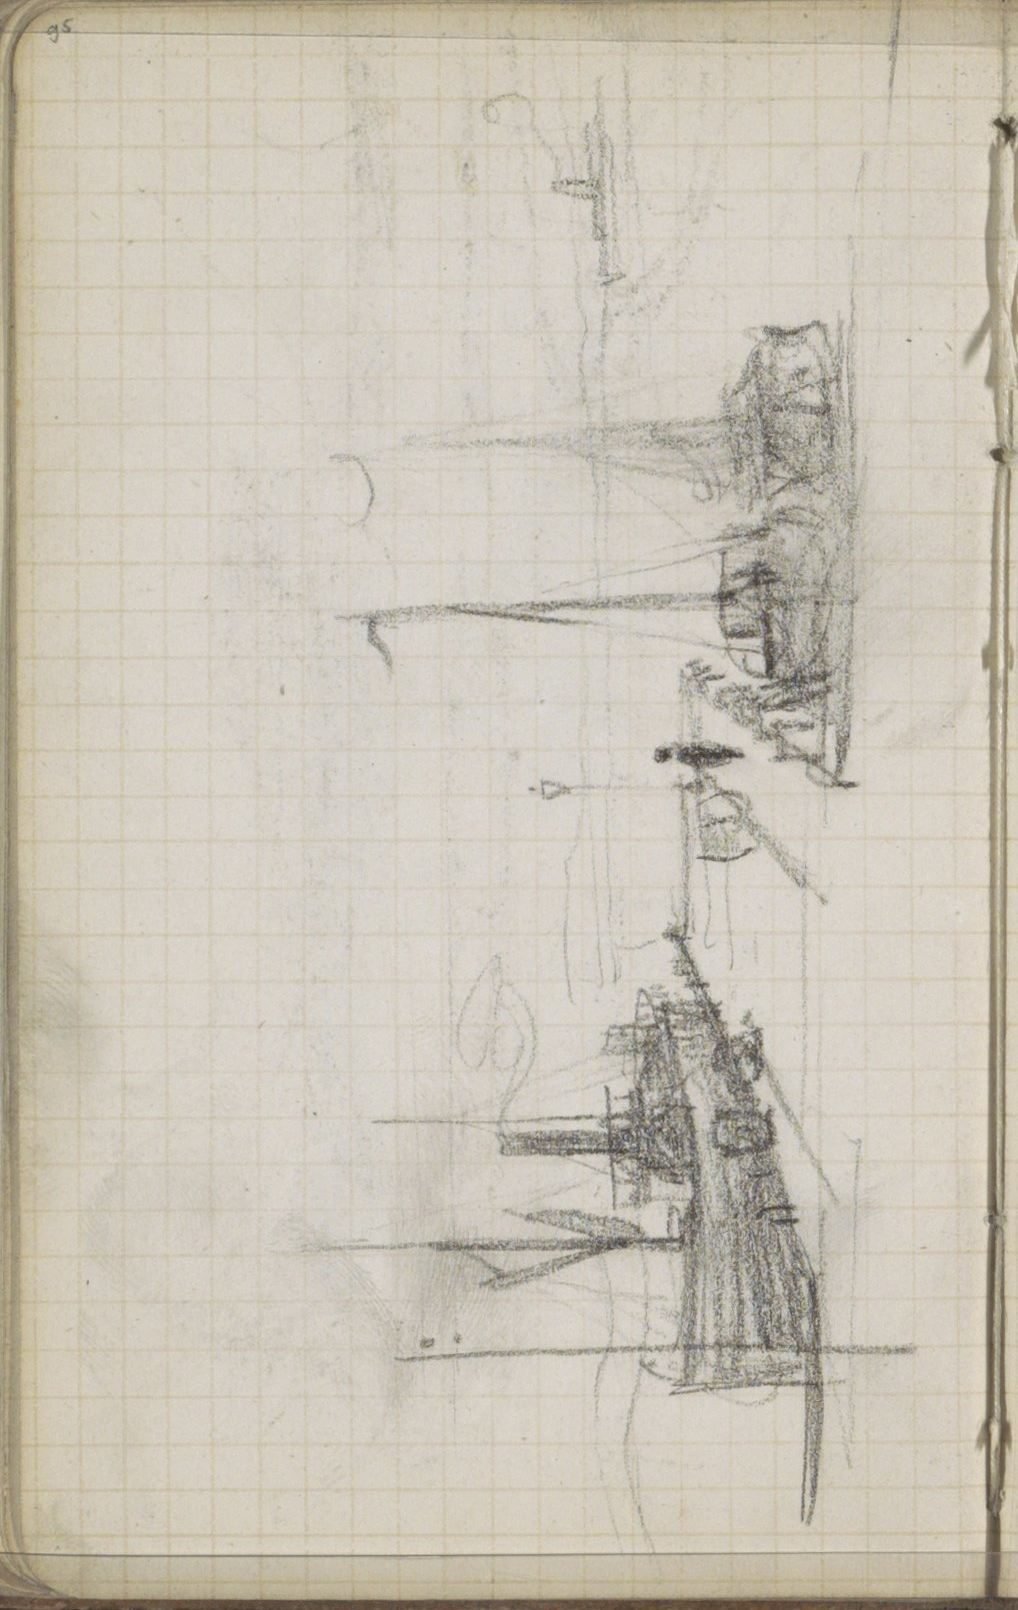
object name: sketchbook leaf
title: Zeilschepen bij een aanlegplaats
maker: marius bauer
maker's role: draughtsman, print maker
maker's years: 1867-1932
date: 1879-1885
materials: chalk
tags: sailing-ship, sailing-boat, pier, quay, wharf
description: Pagina 95 uit een schetsboek met 58 bladen.